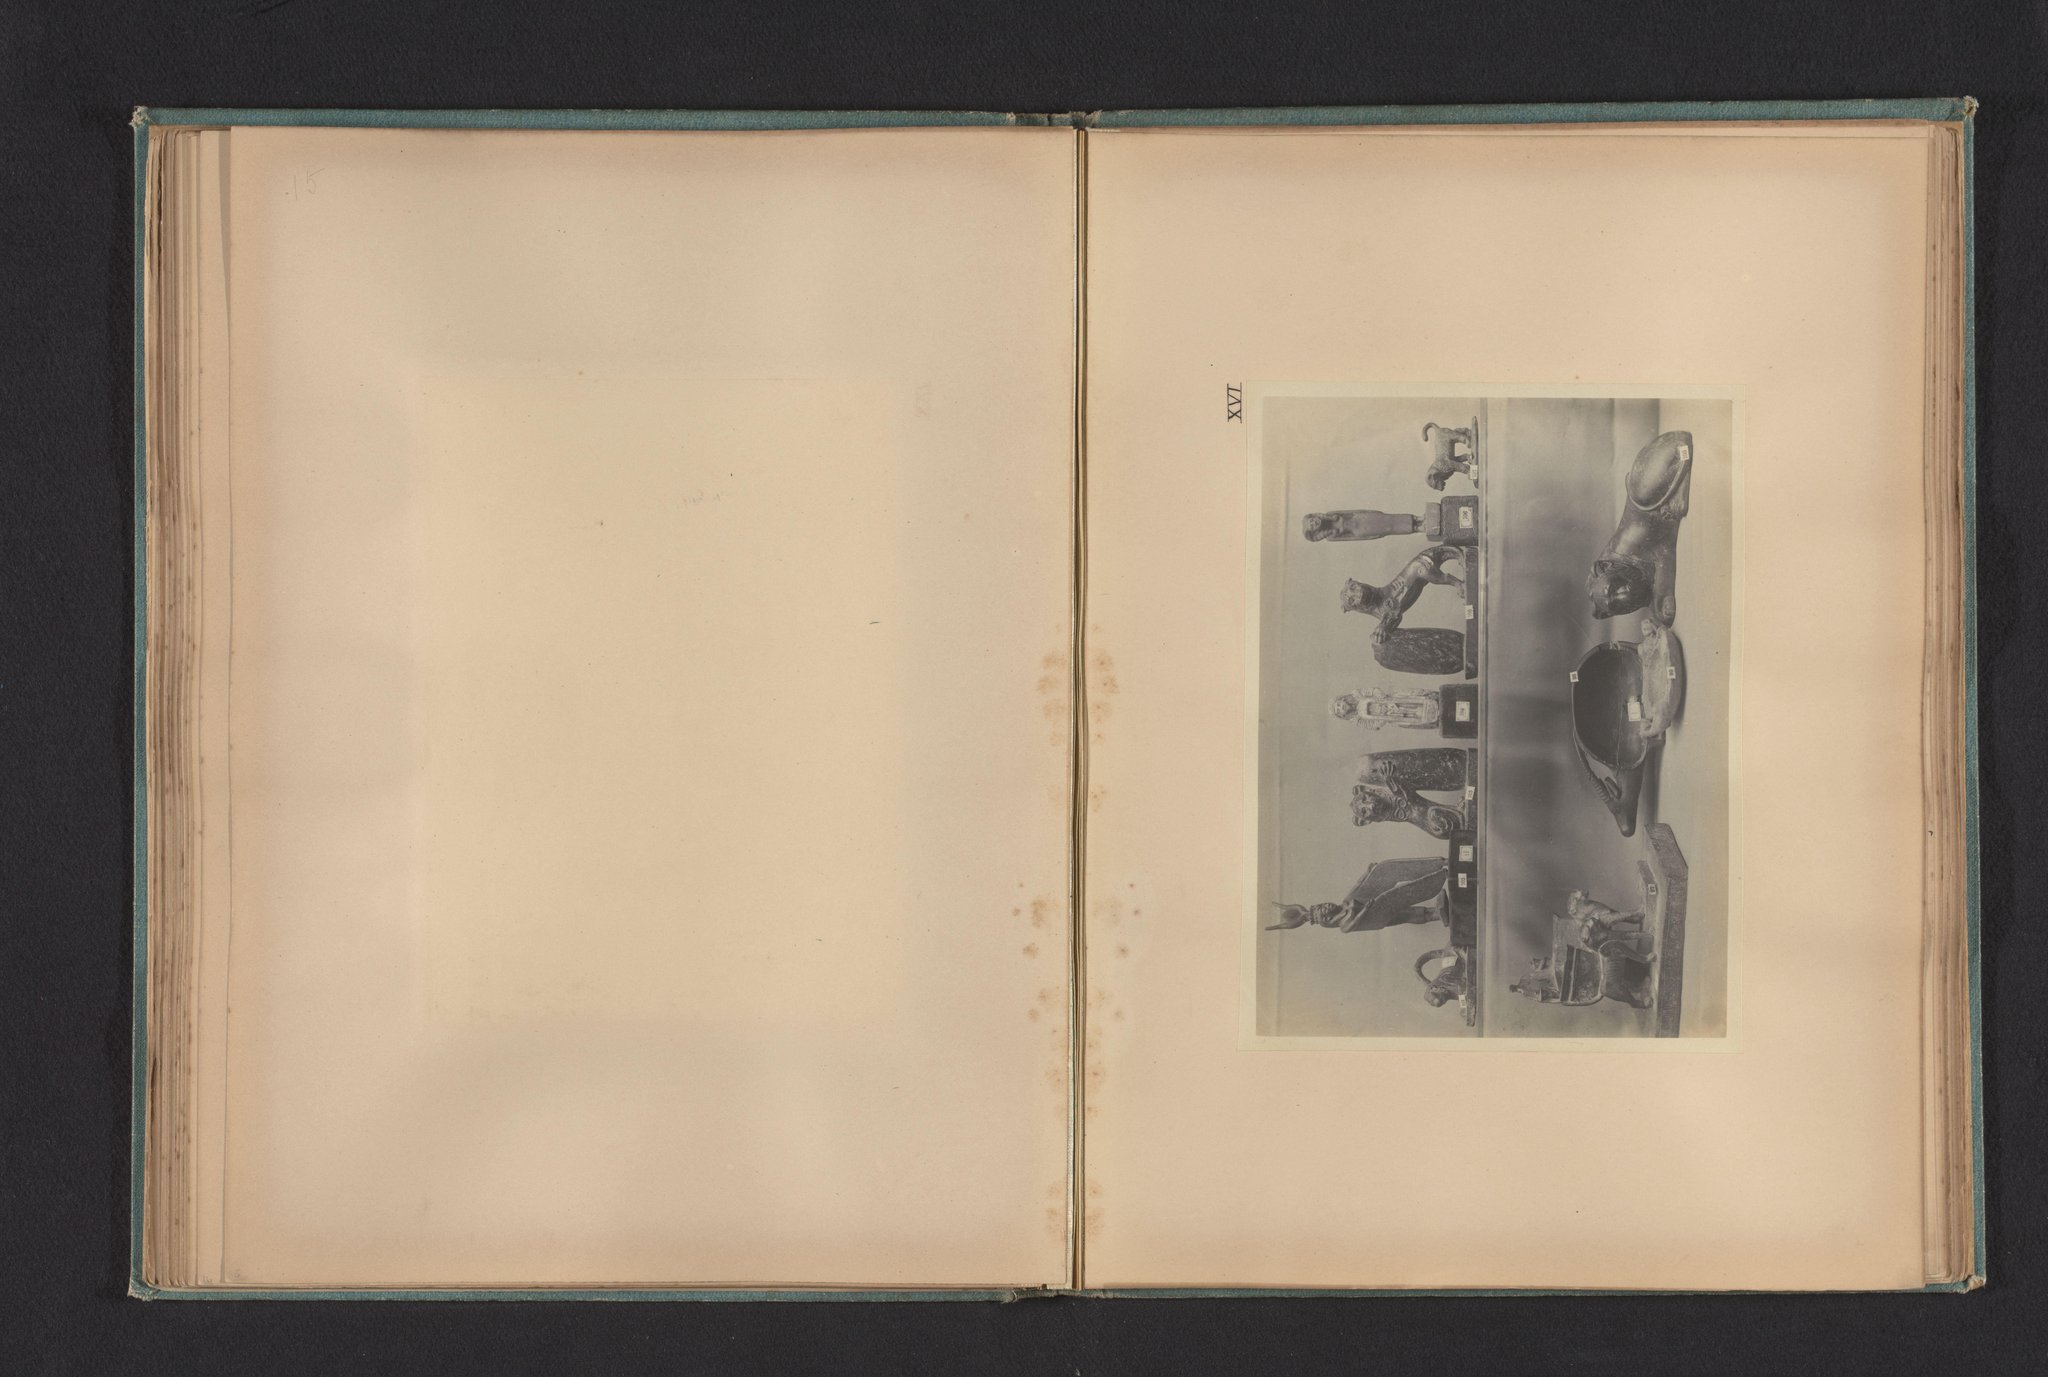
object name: page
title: Elf Egyptische objecten, waaronder een sculptuur van Isis en een sculptuur van een troon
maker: Anonymous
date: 1890-1895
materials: photographic support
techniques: gelatin silver print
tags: isis, the mother-goddess, throne, sculpture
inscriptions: number: ‘XVI’